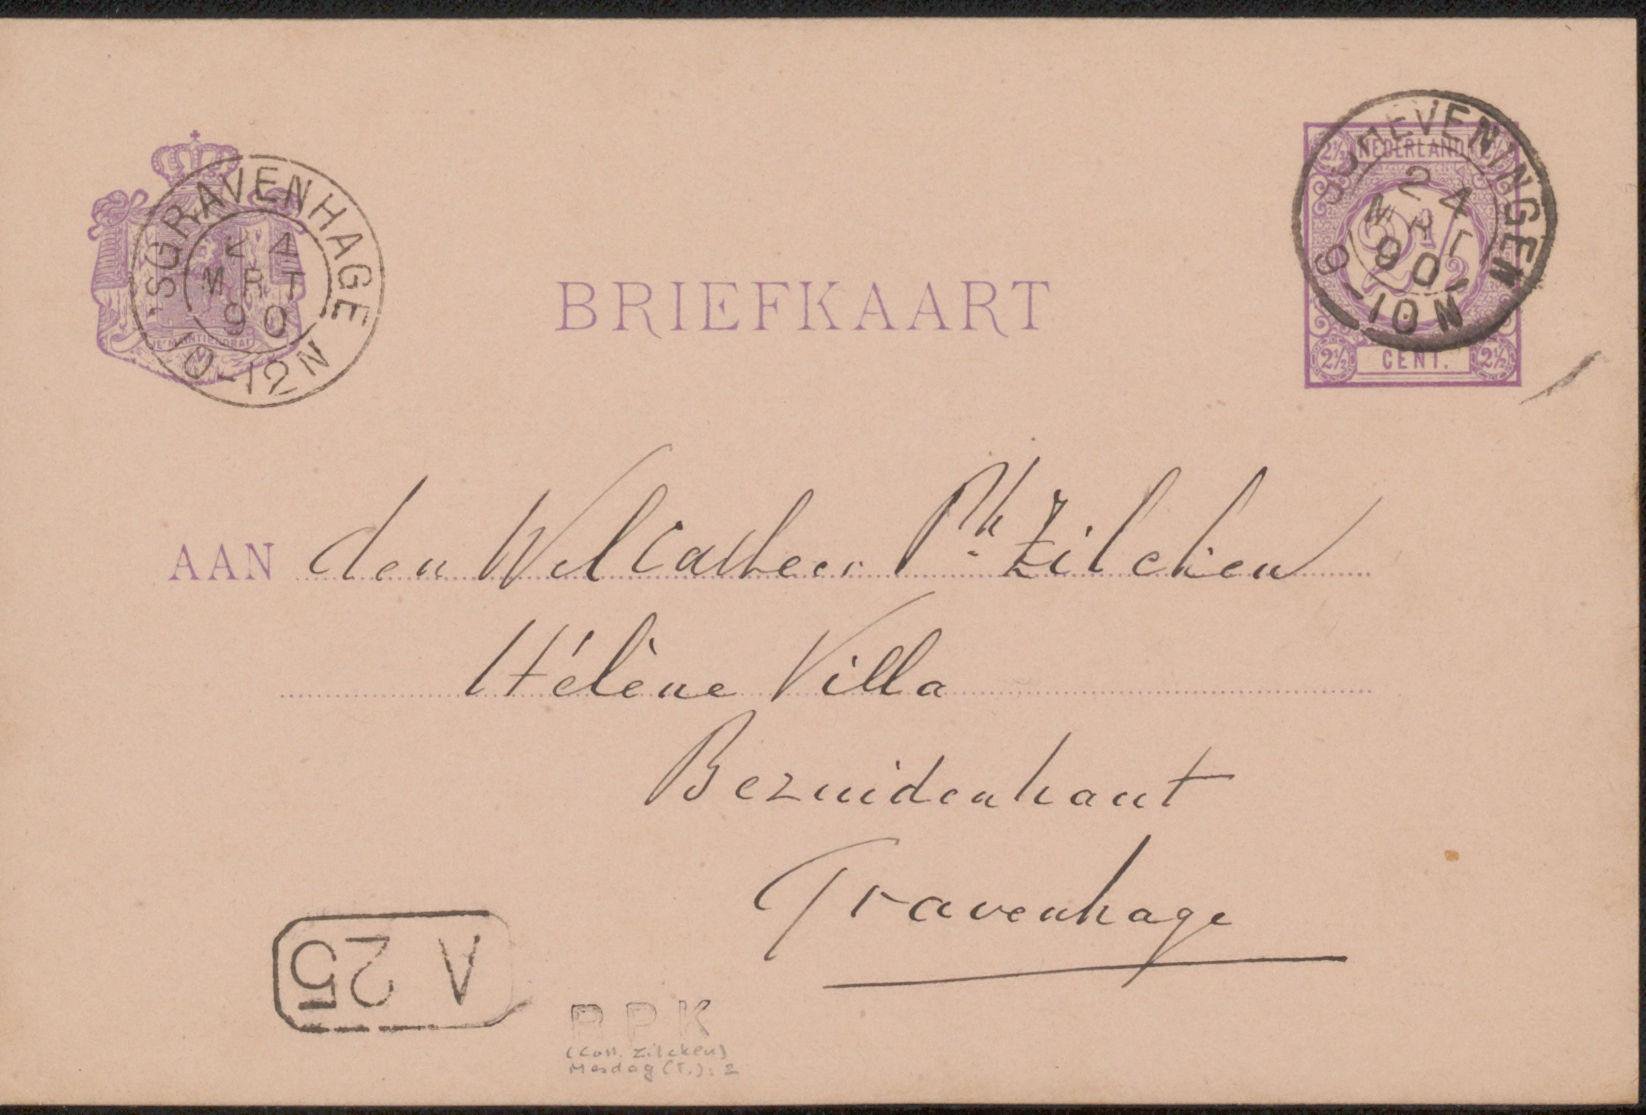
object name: postcard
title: Briefkaart aan Philip Zilcken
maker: taco mesdag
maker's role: draughtsman, painter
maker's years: 1829-1902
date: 1890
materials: cardboard, ink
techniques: pen, writing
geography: scheveningen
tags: the hague, painter, draughtsman, philip zilcken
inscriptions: collector's mark: ‘RPK’